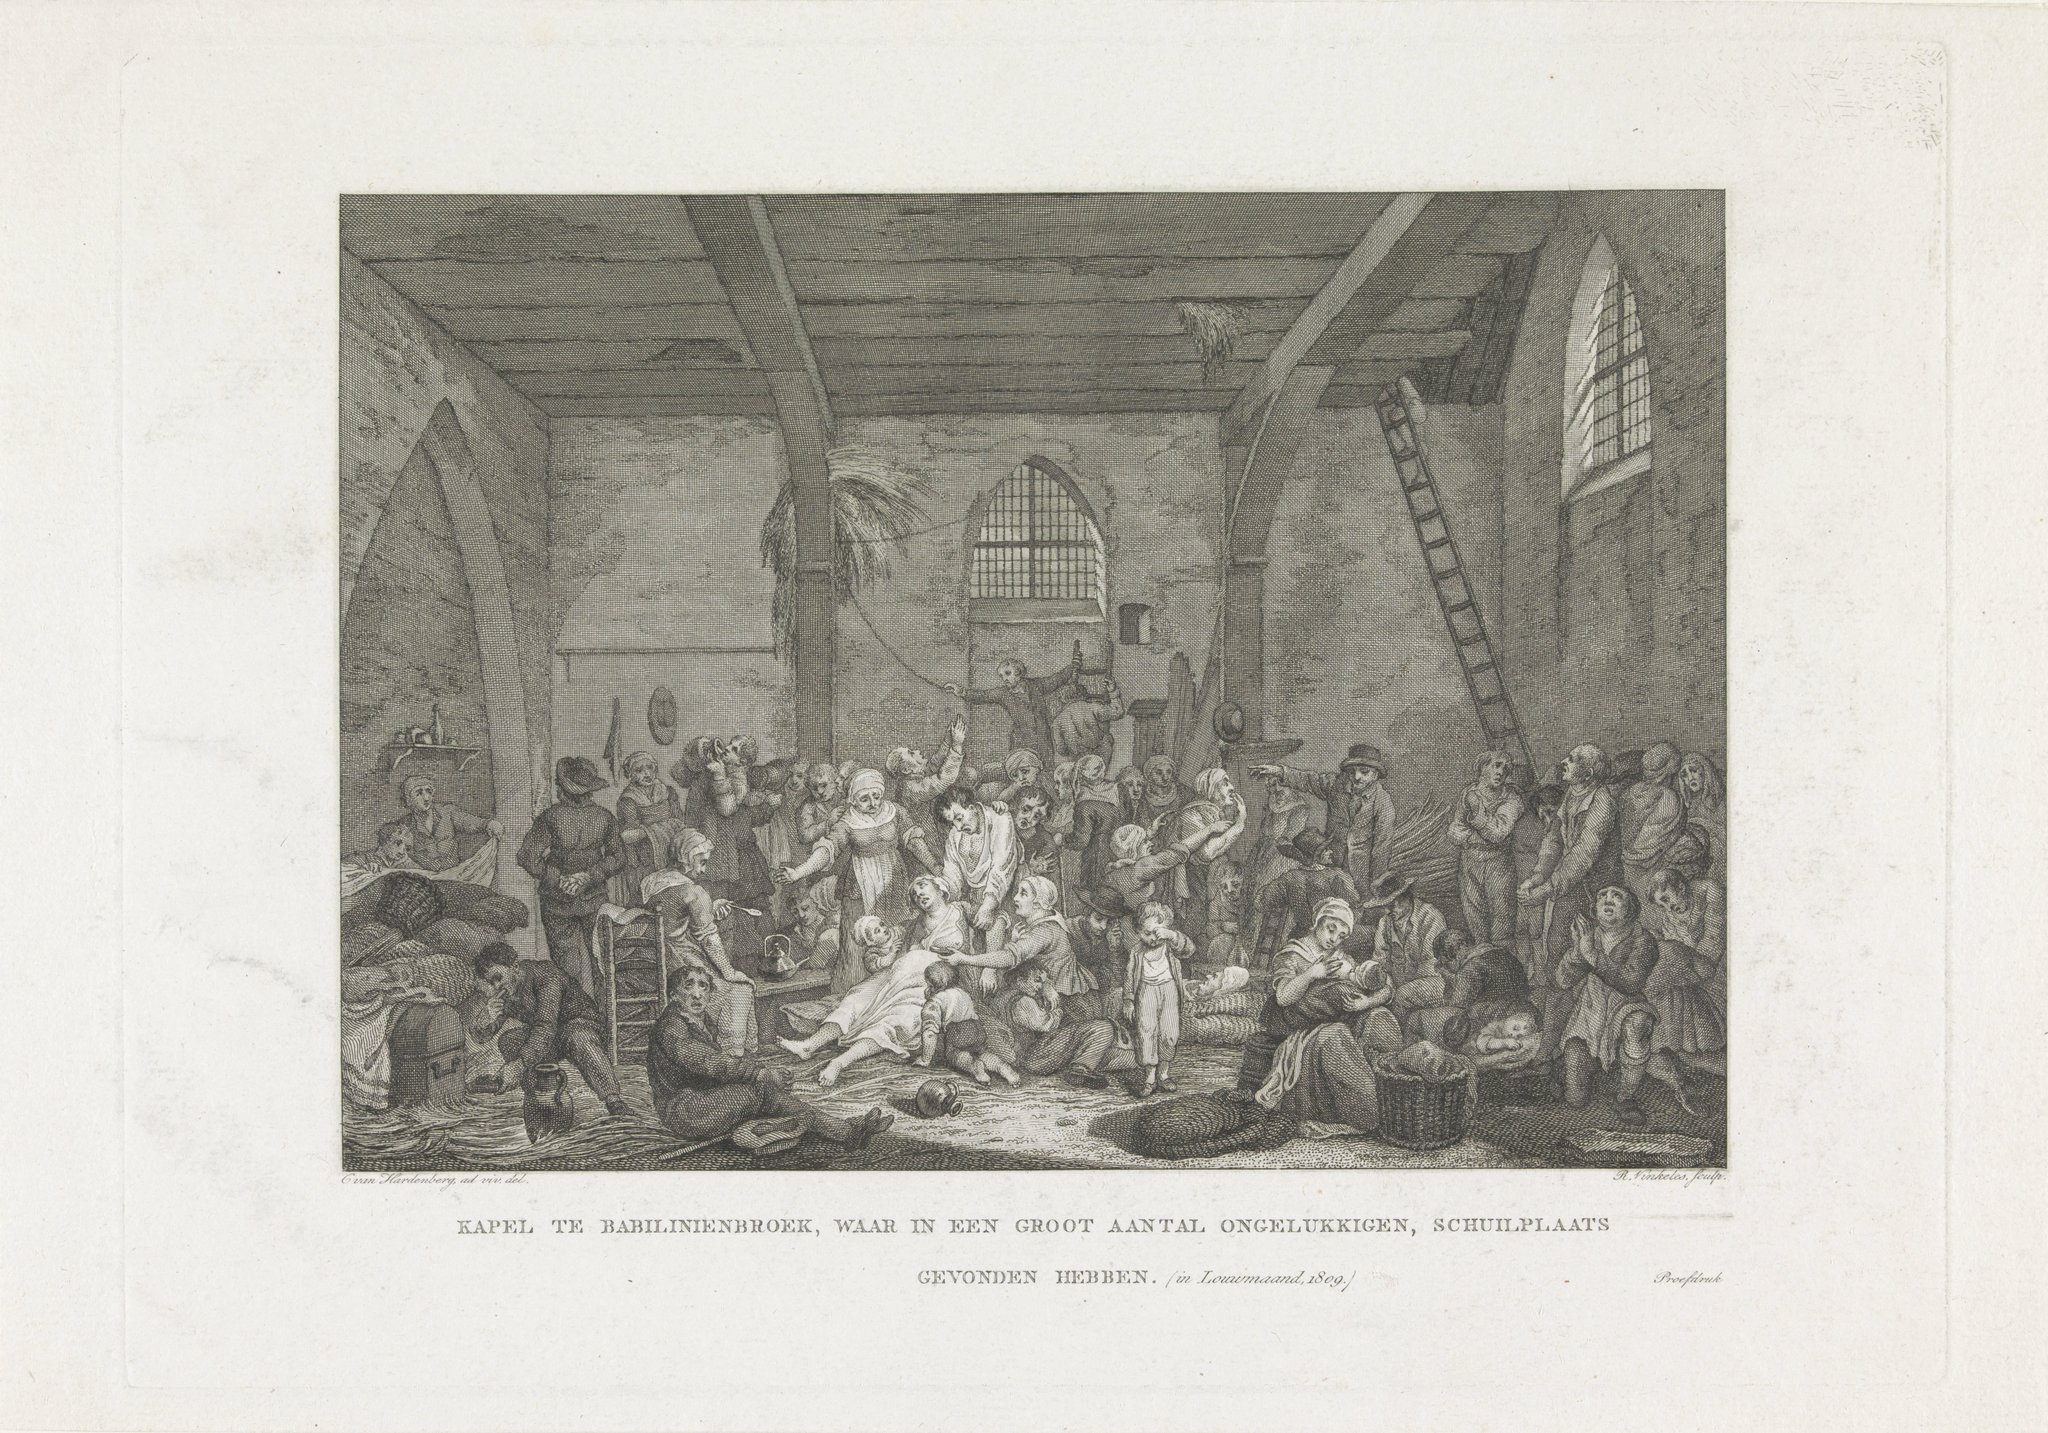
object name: print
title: Kapel te Babilinienbroek, waar in een groot aantal ongelukkigen, schuilplaats gevonden hebben (in Louwmaand, 1809.)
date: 1809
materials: paper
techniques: engraving, etching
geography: netherlands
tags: dike-break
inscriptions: collector's mark: Lugt 2228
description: Gebruikt als illustratie in: Hendrik Ewijk. Geschiedkundig verslag der dijkbreuken en overstroomingen, langs de rivieren in het Koningrijk Holland, voorgevallen in louwmaand MDCCCIX. 3 dln. Amsterdam: Johannes Allart en Jacobus Ruys, 1809.